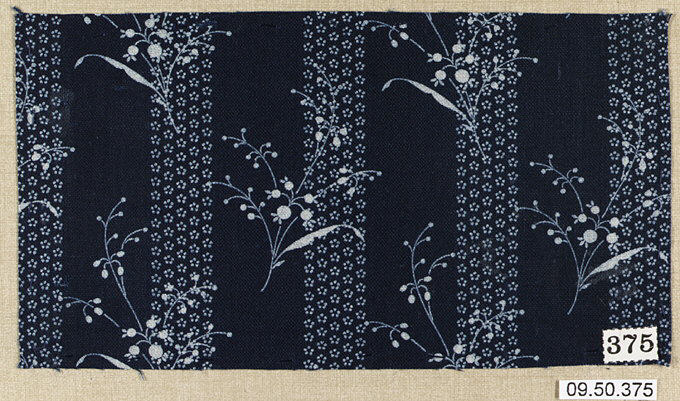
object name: piece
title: Piece (one of 116)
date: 1801-1900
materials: cotton